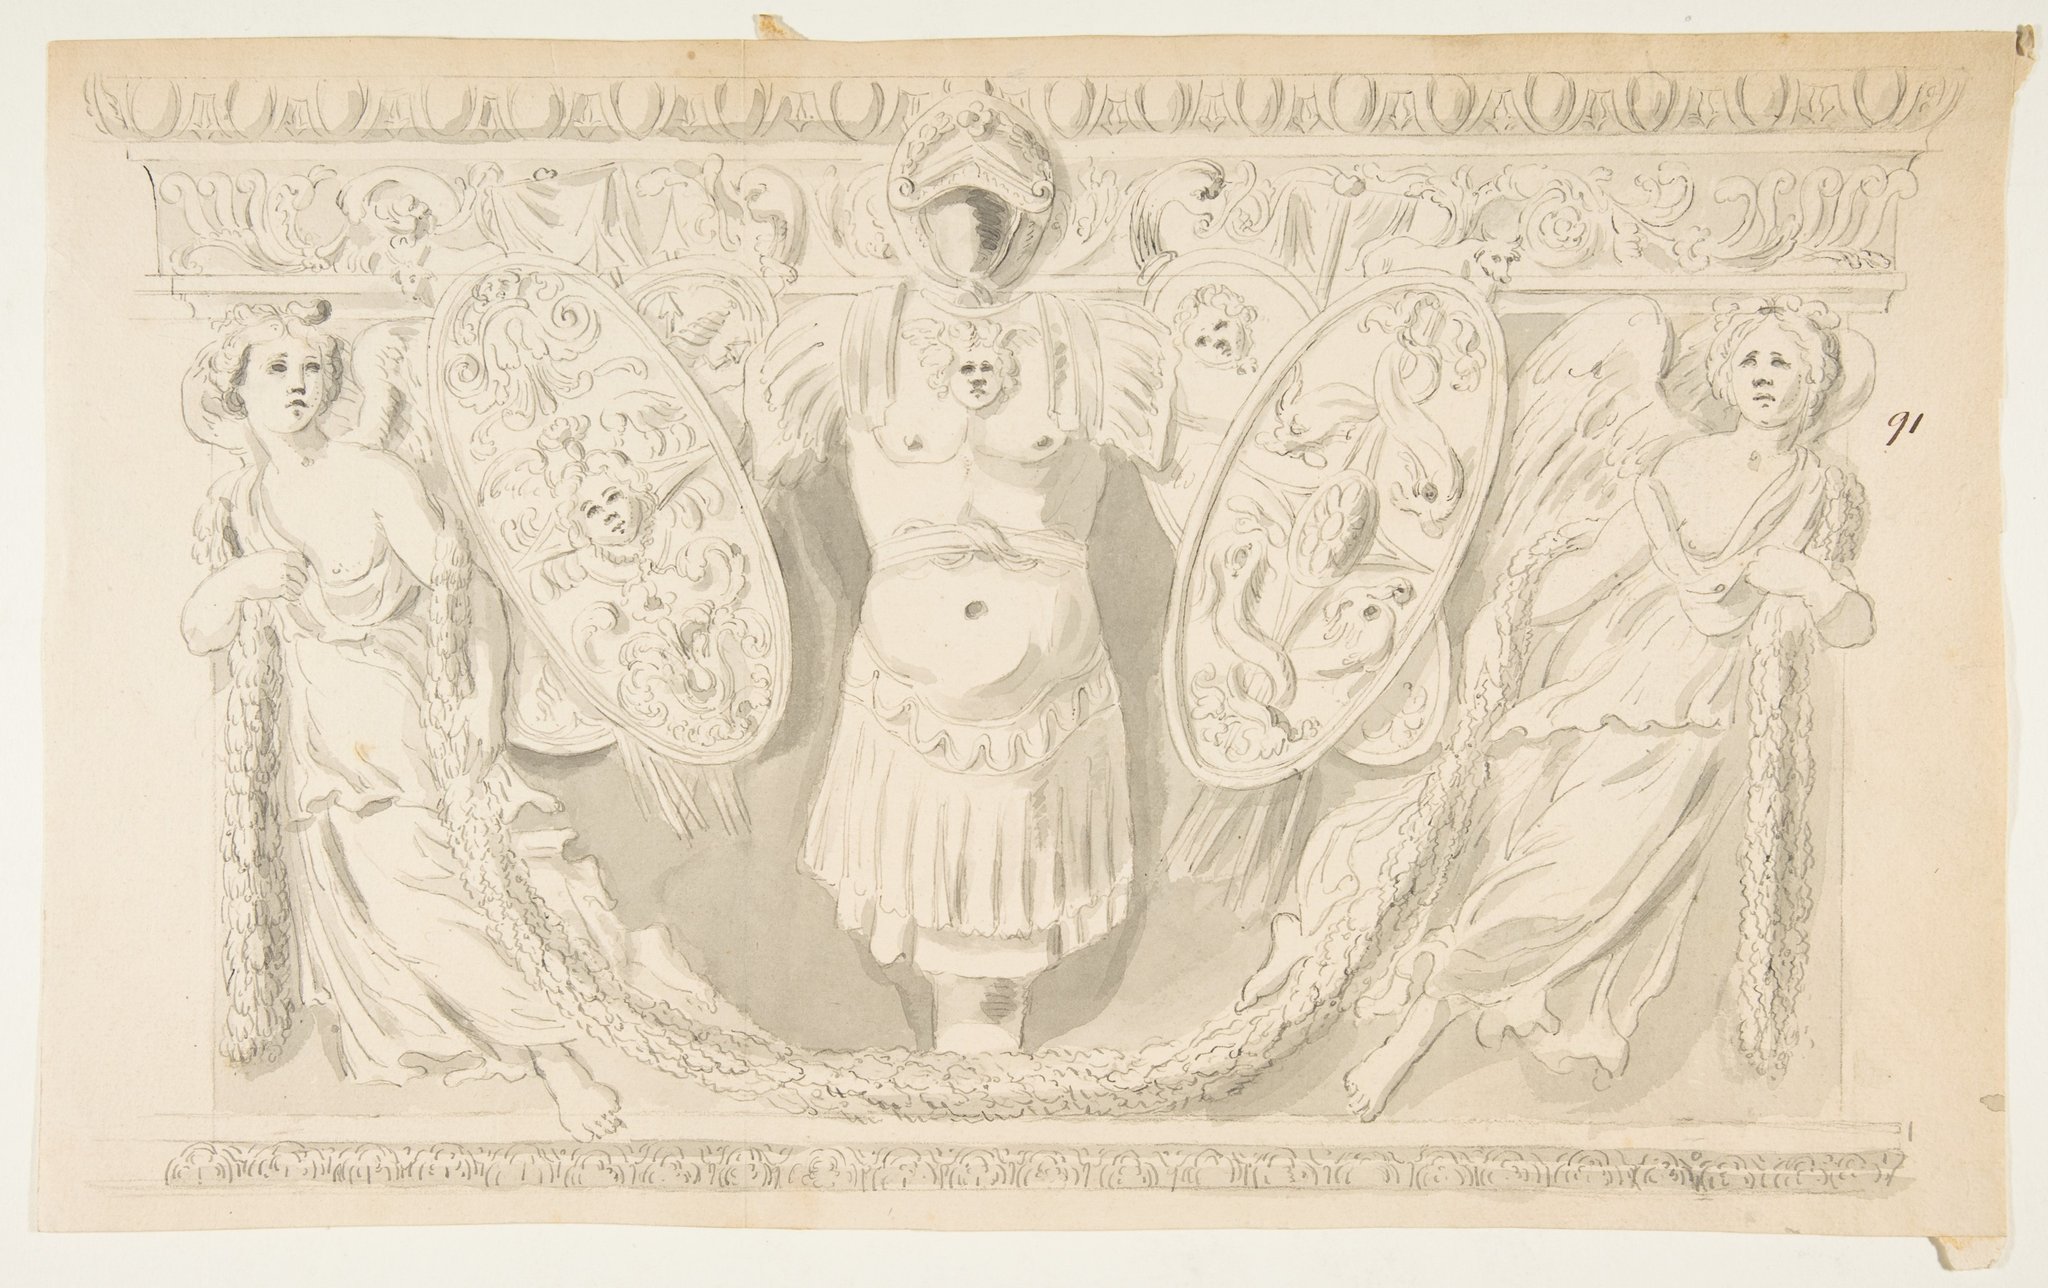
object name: drawing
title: Design after a Roman Frieze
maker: anonymous, french, 18th century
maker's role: artist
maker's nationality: french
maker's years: 1700-1800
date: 1701-1800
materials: graphite, ink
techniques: brush, pen, wash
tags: armor,shields,women